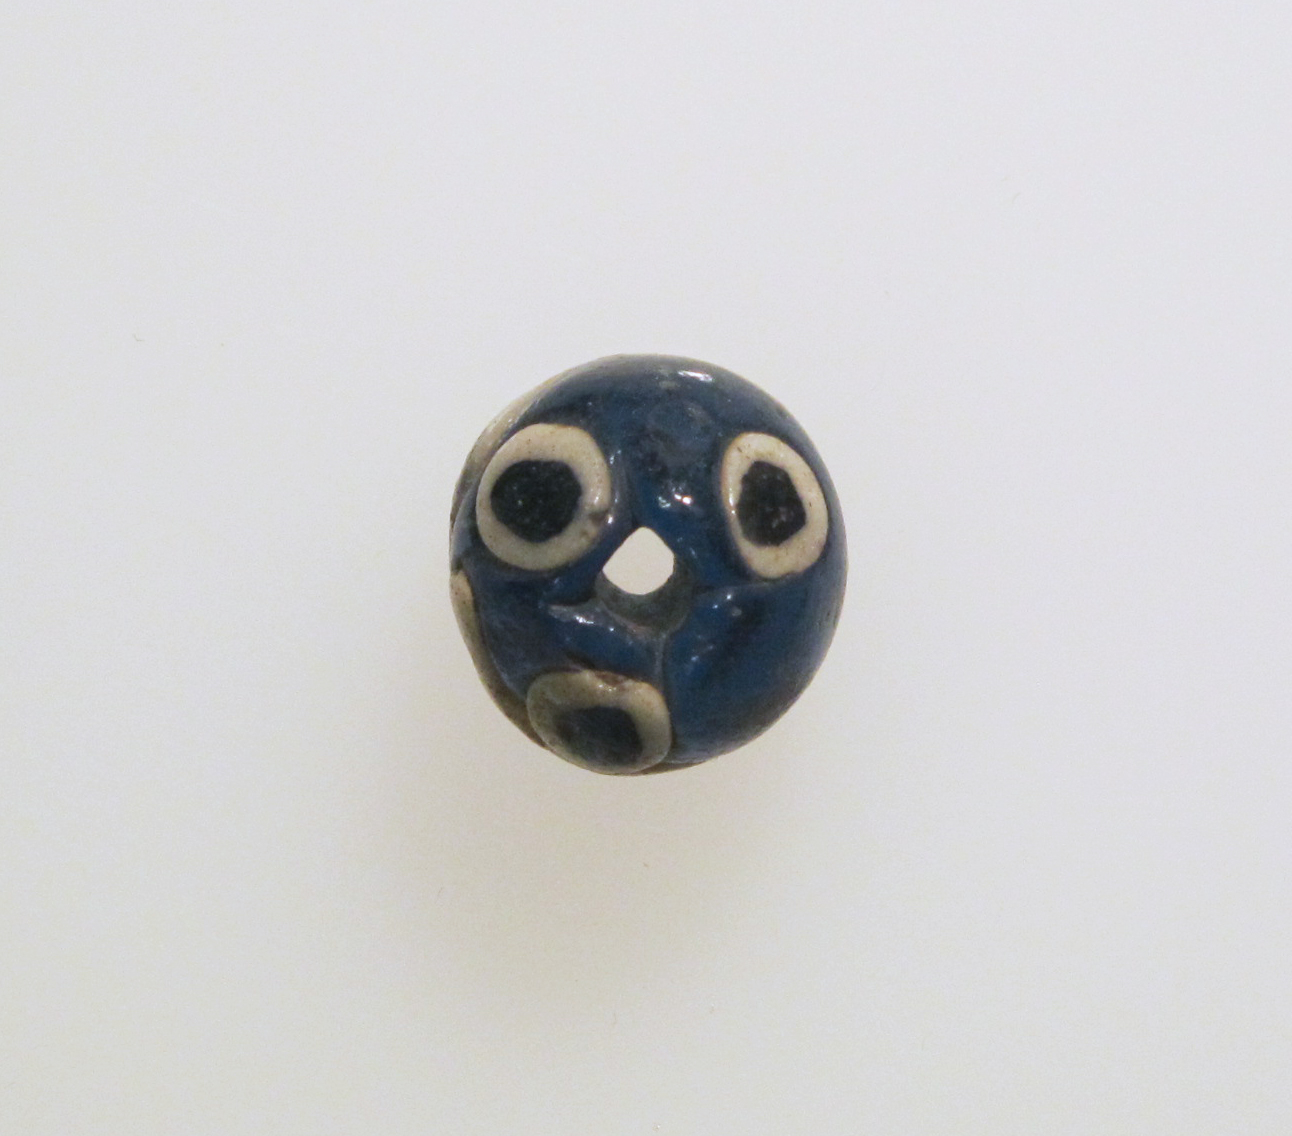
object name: bead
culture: roman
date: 670 BCE-330 CE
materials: glass